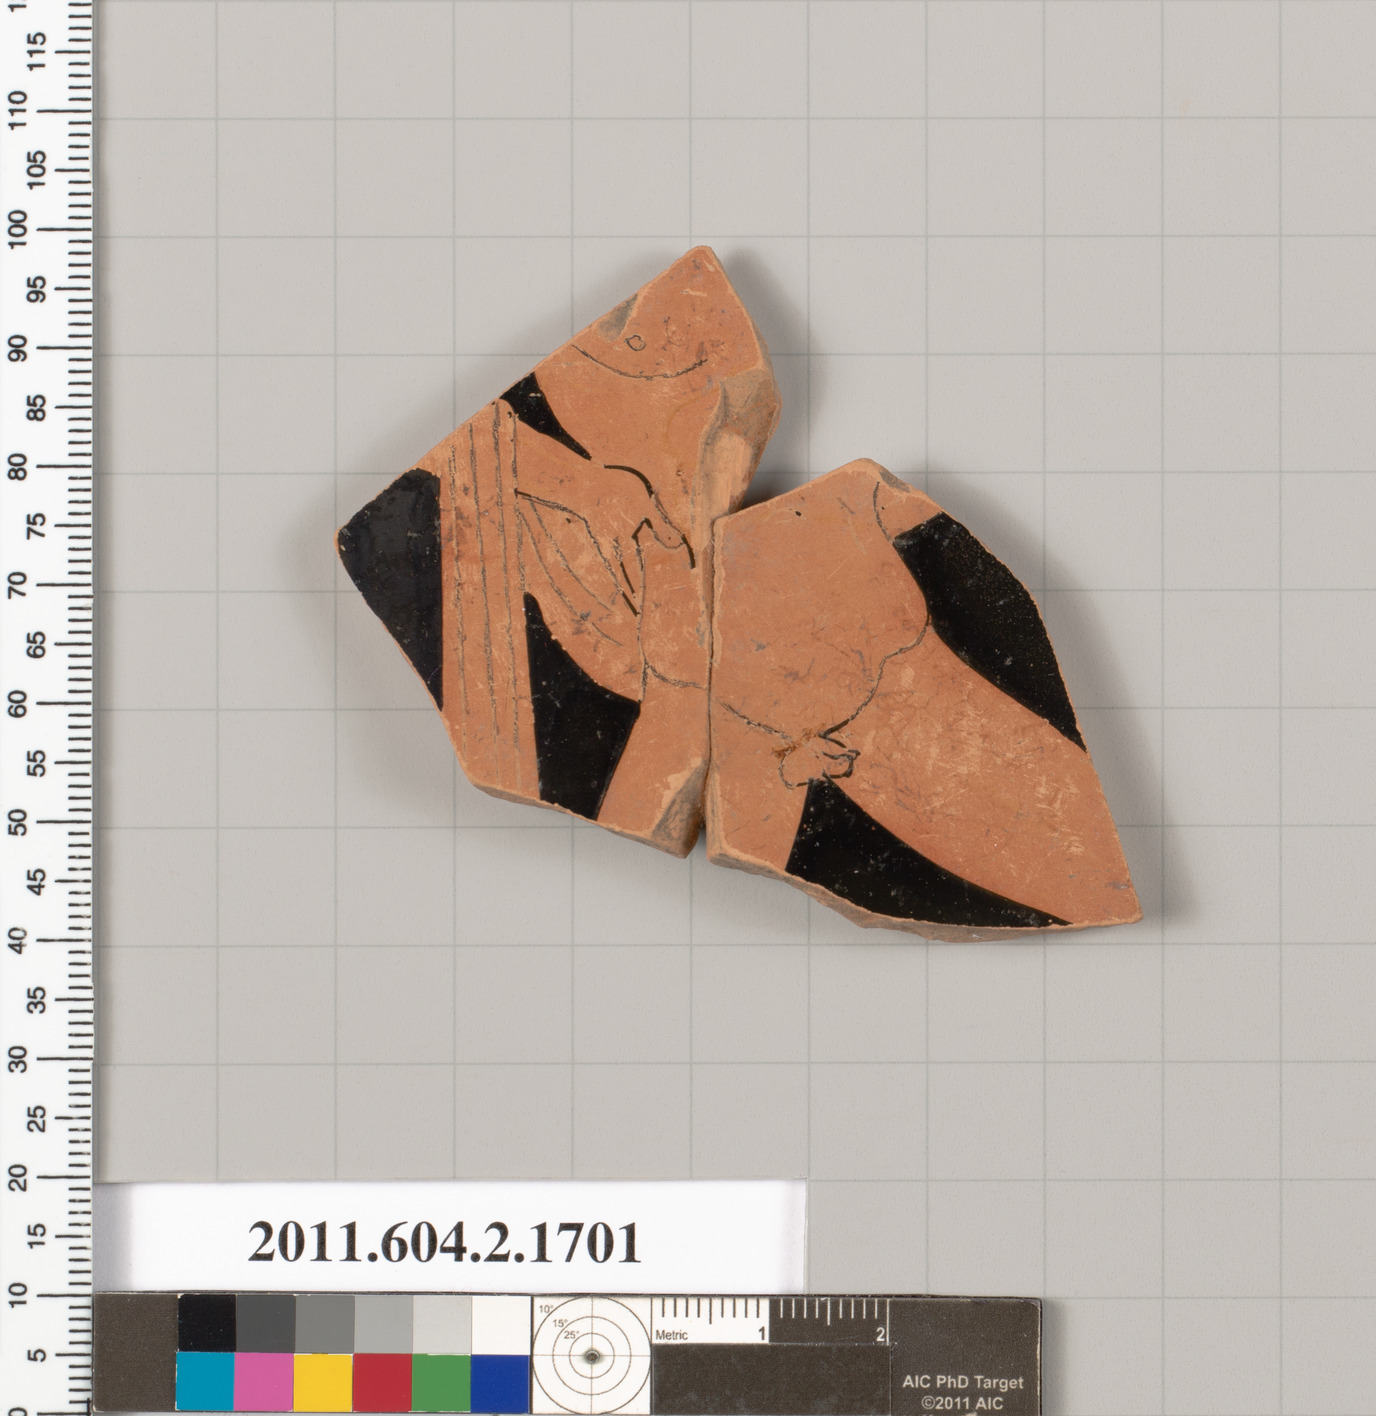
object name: skyphos fragment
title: Terracotta fragment of a skyphos (deep drinking cup)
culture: greek, attic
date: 450-426 BCE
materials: terracotta